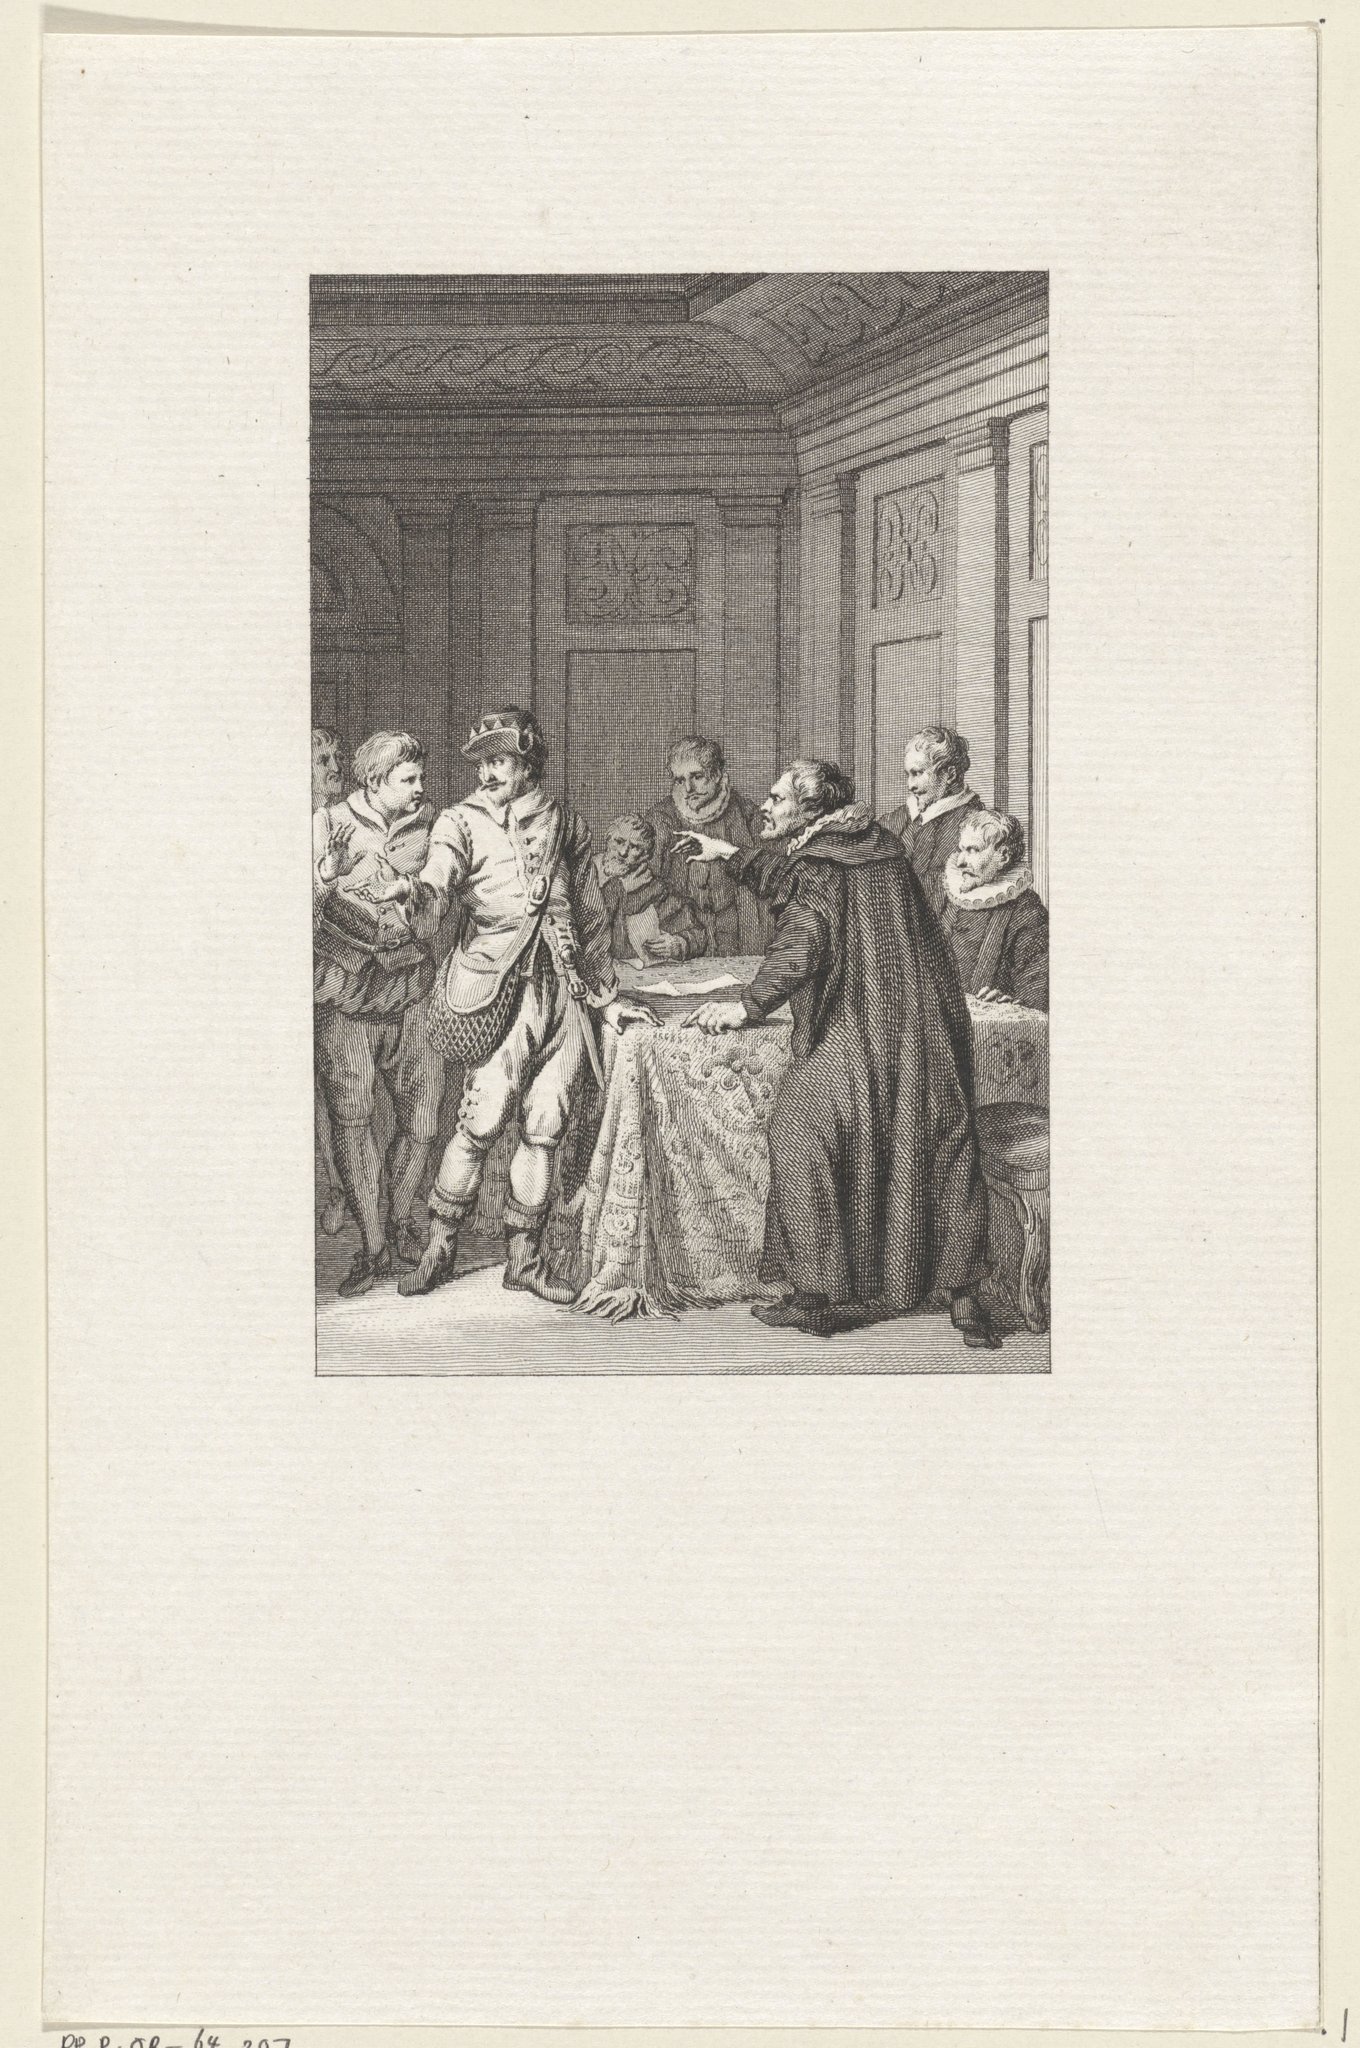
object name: print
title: Alfons IV, koning van Portugal berispt door een raadsheer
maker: reinier vinkeles (i)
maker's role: draughtsman, print maker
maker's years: 1741-1816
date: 1785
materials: paper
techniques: engraving, etching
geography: amsterdam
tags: hunter, game bag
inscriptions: collector's mark: Lugt 240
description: Latere staat prent gebruikt als boekillustratie in: Martinet, Joannes Florentius. Historie der waereld. Amsterdam: Johannes Allart, 1780-1788. 25 delen. deel VI, pl. II.